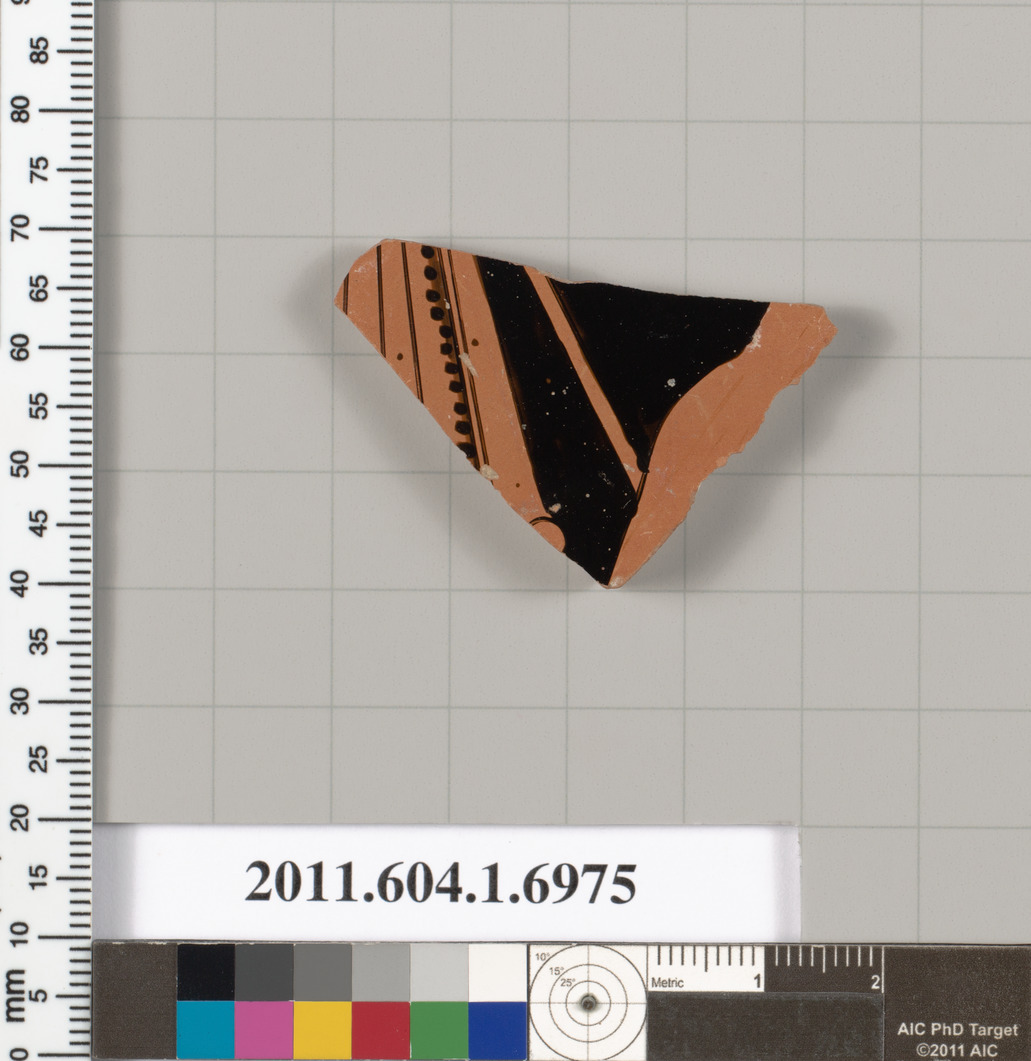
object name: kylix fragment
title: Terracotta fragment of a kylix (drinking cup)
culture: greek, attic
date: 490-470 BCE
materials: terracotta